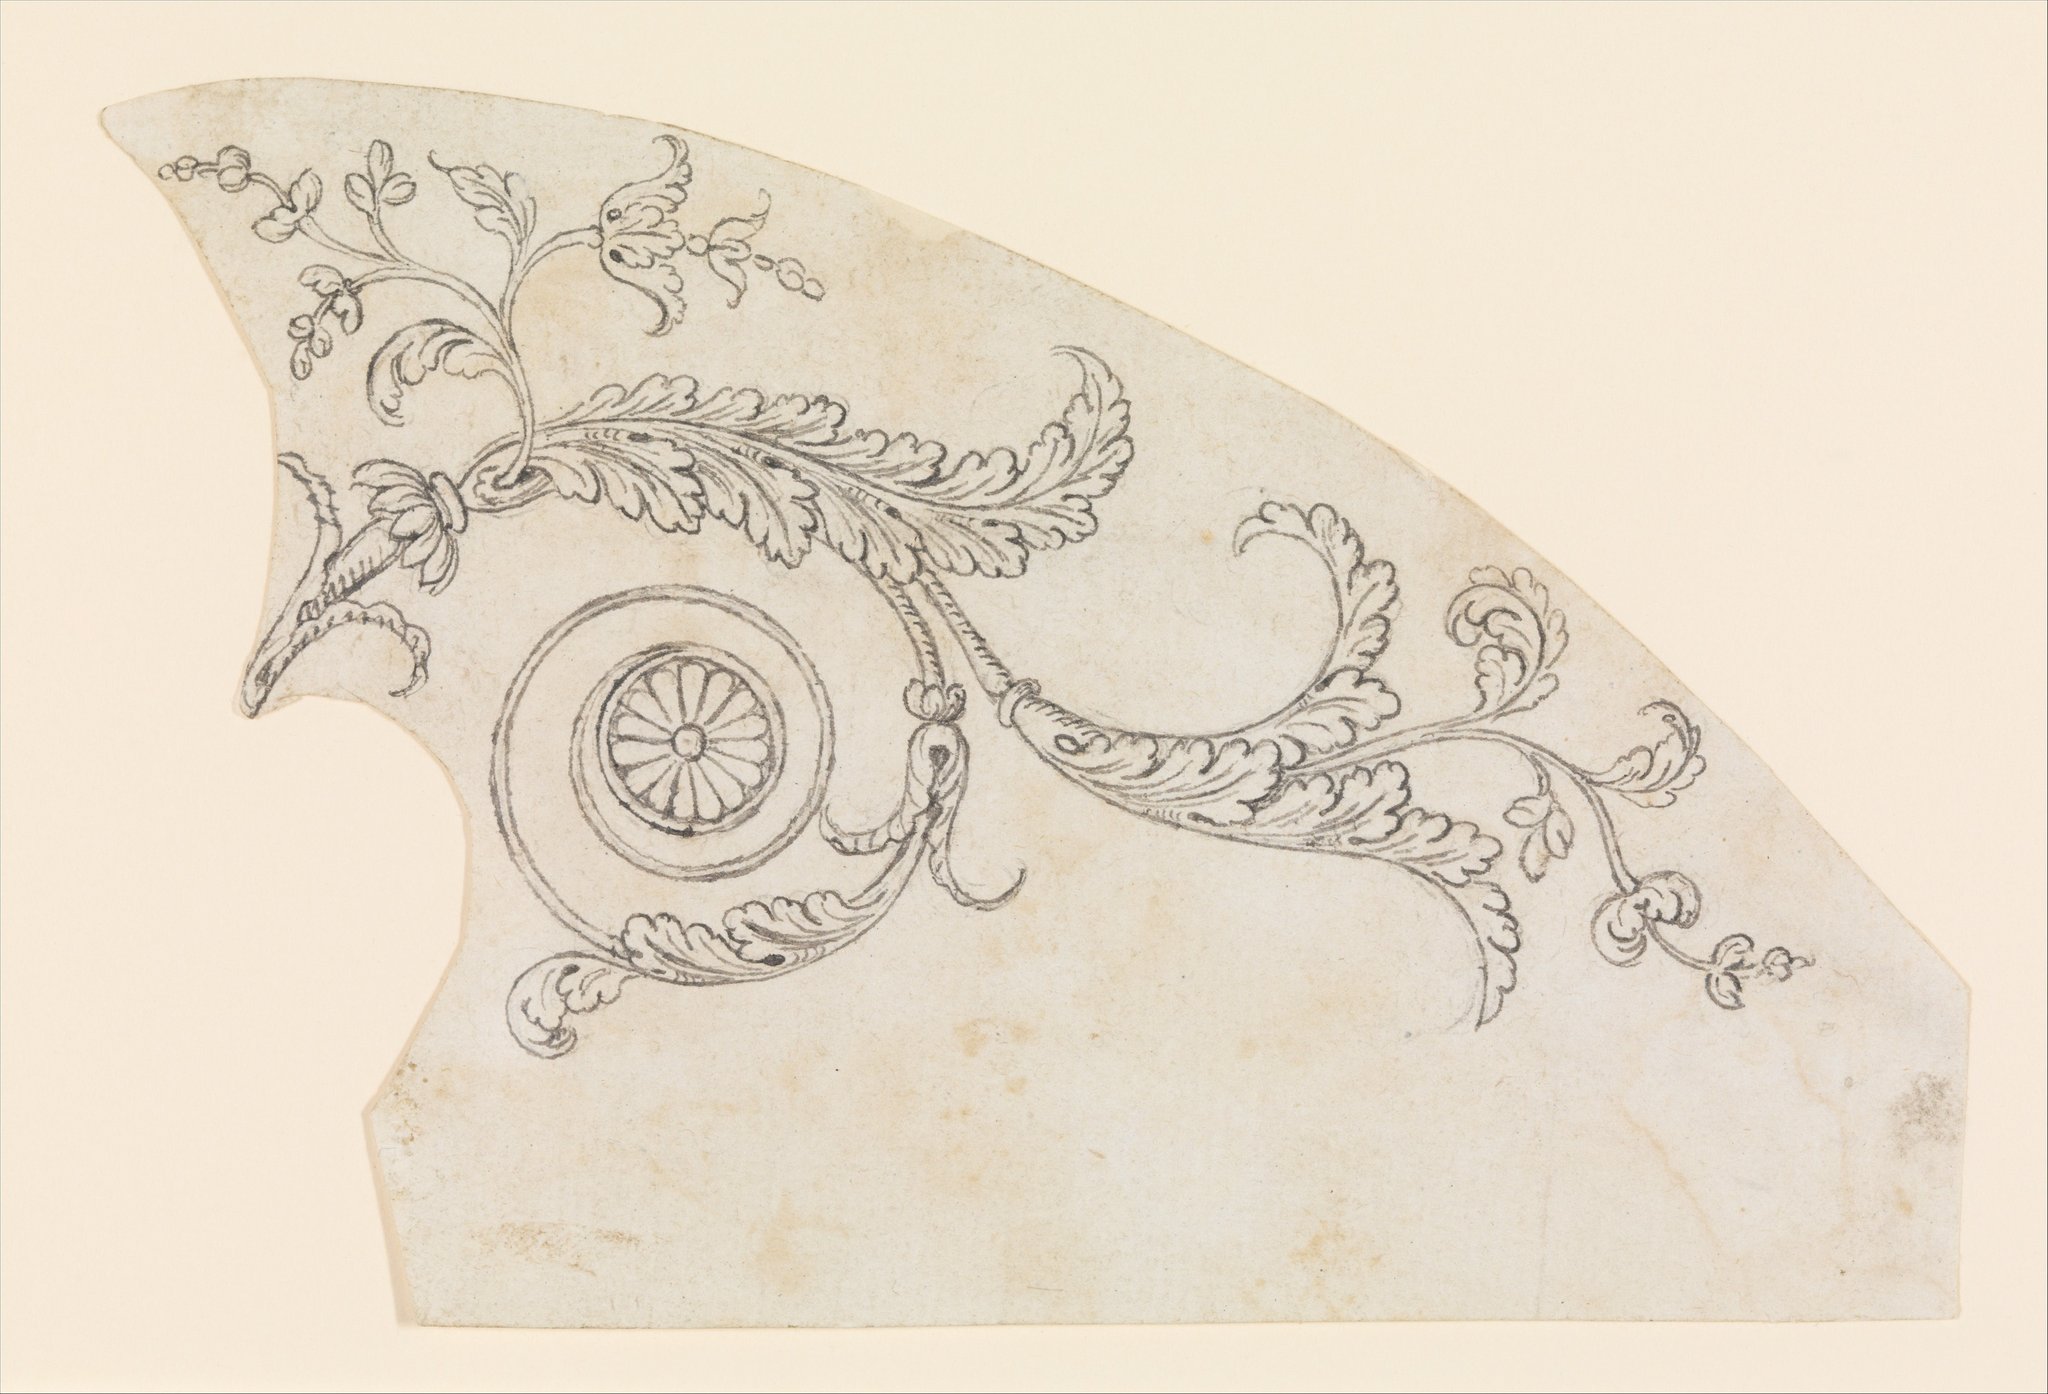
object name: drawing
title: Design for the Decoration of Firearms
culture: french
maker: nicolas noël boutet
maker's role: designer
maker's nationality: french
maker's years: 1761-1833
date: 1795-1805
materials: ink, paper, pencil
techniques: wash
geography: france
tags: ornament